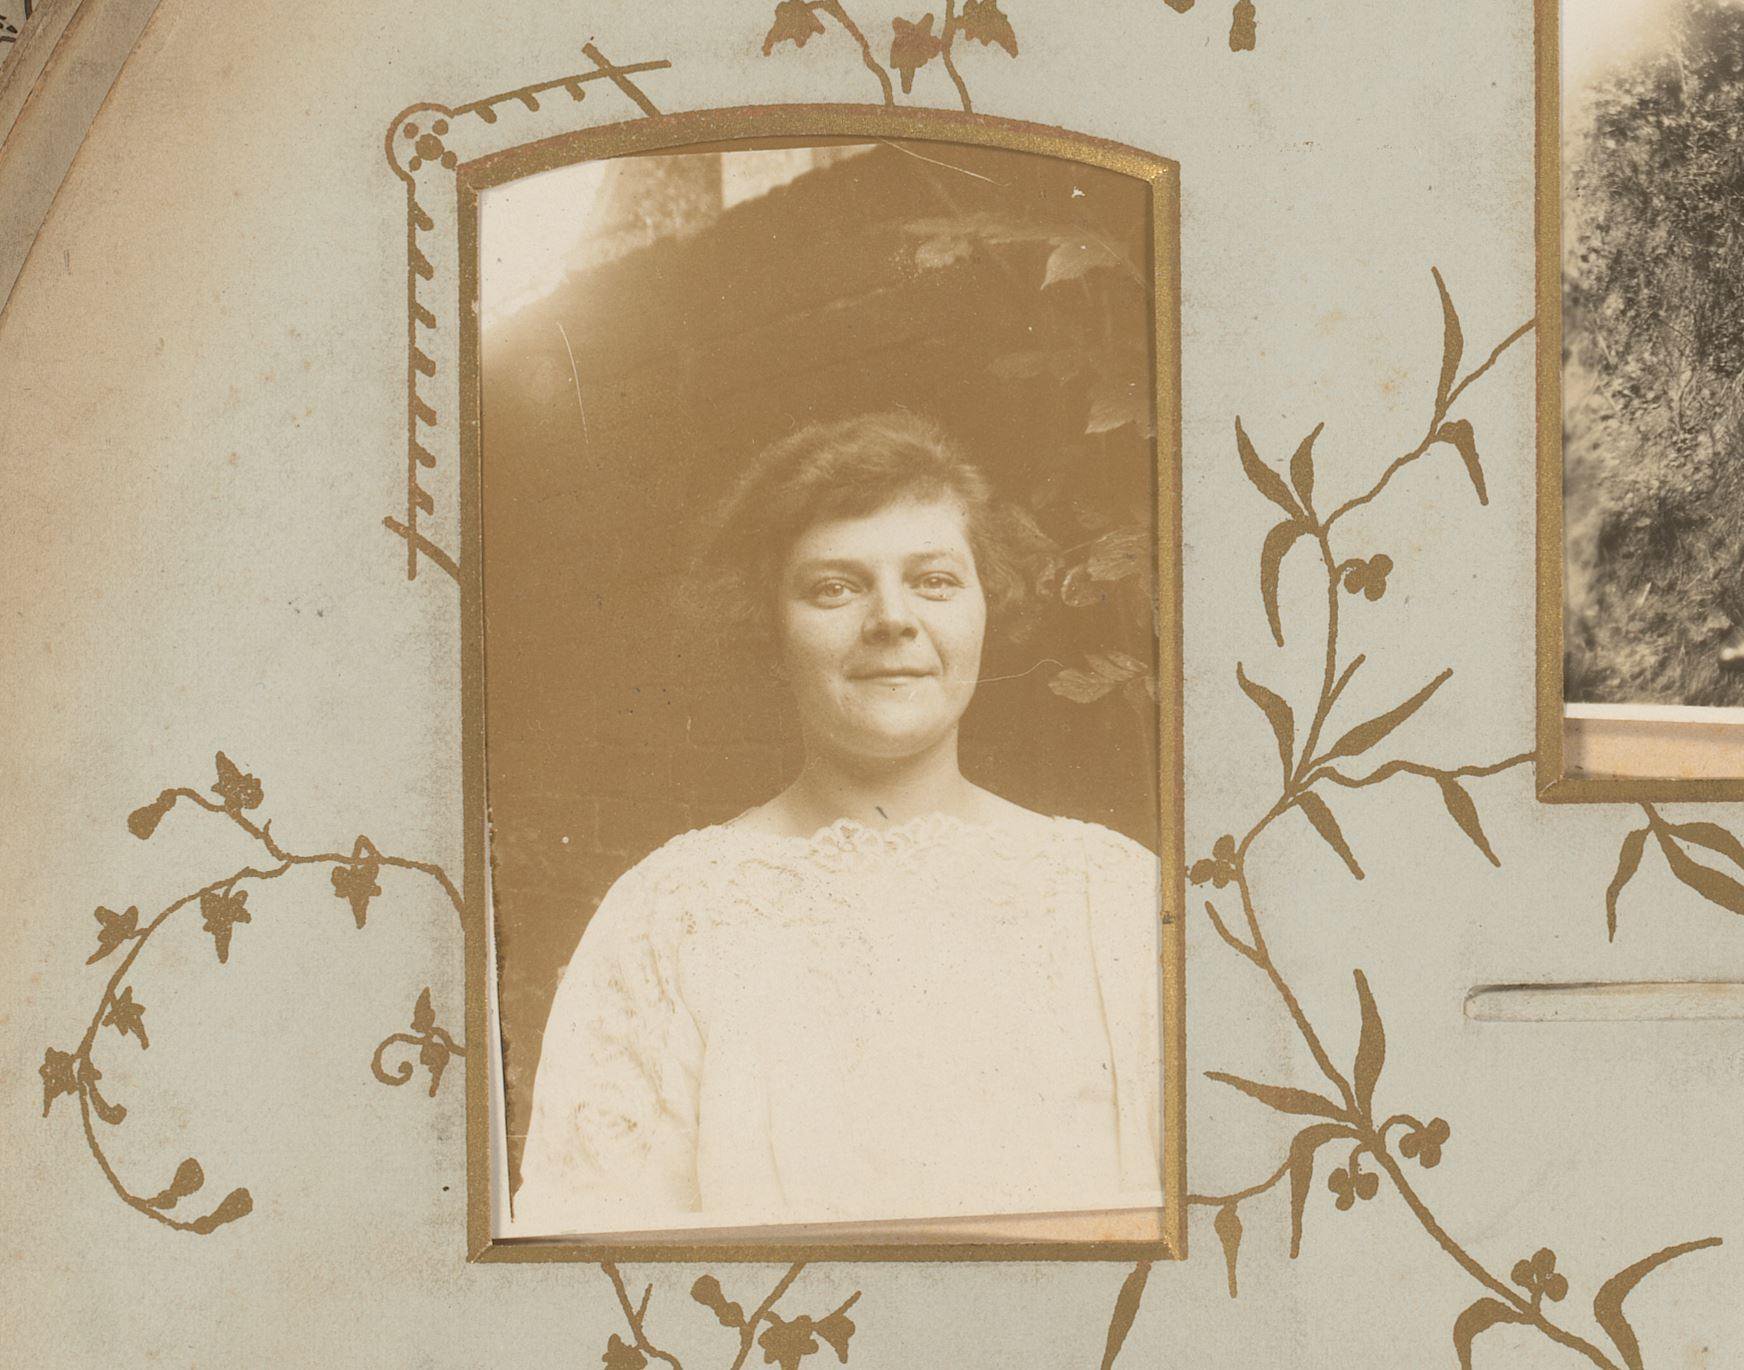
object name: album leaf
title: San-tan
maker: Anonymous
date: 1899-1920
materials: photographic support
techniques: gelatin silver print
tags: adult woman, historical persons